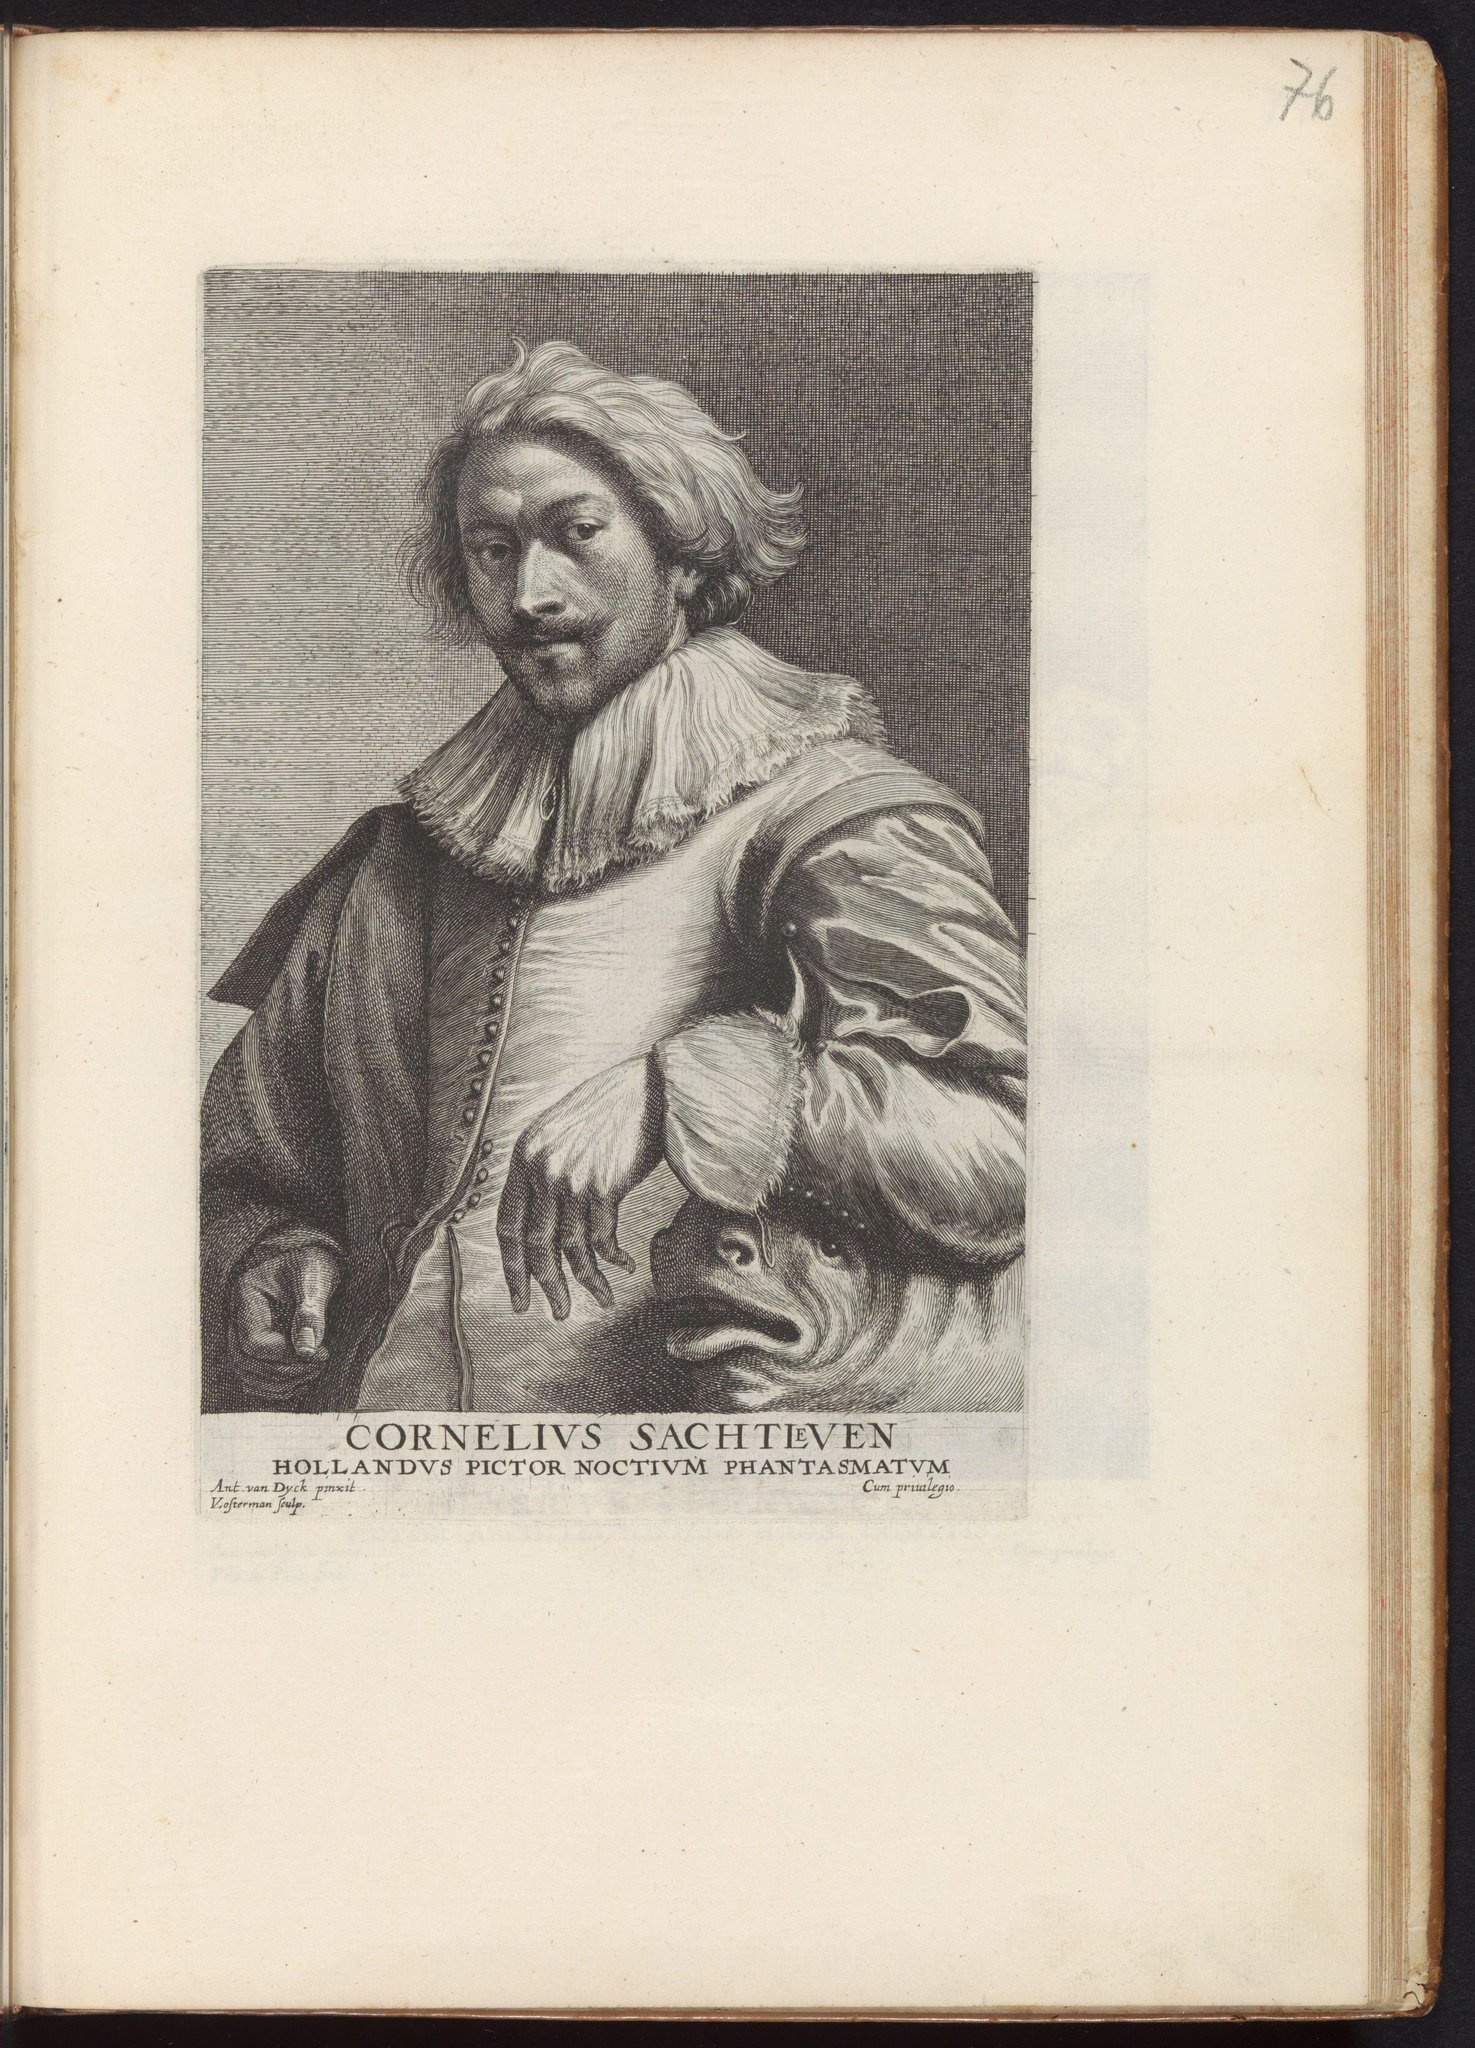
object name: print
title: Icones Principum Vivorum Doctorum Pictorum Chalcographorum Statuariorum nec non Amatorum Pictoriae Artis Numero Centum ab Antonio van Dyck Pictore ad Vivum Expressae Eiusq: Sumptibus aeri incisae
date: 1630-1641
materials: paper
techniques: engraving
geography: antwerp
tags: rotterdam, print maker, draughtsman, cornelis saftleven, portrait, self-portrait of painter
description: Portret van de prentmaker, tekenaar en schilder Cornelis Saftleven. Deze prent maakt deel uit van een album.